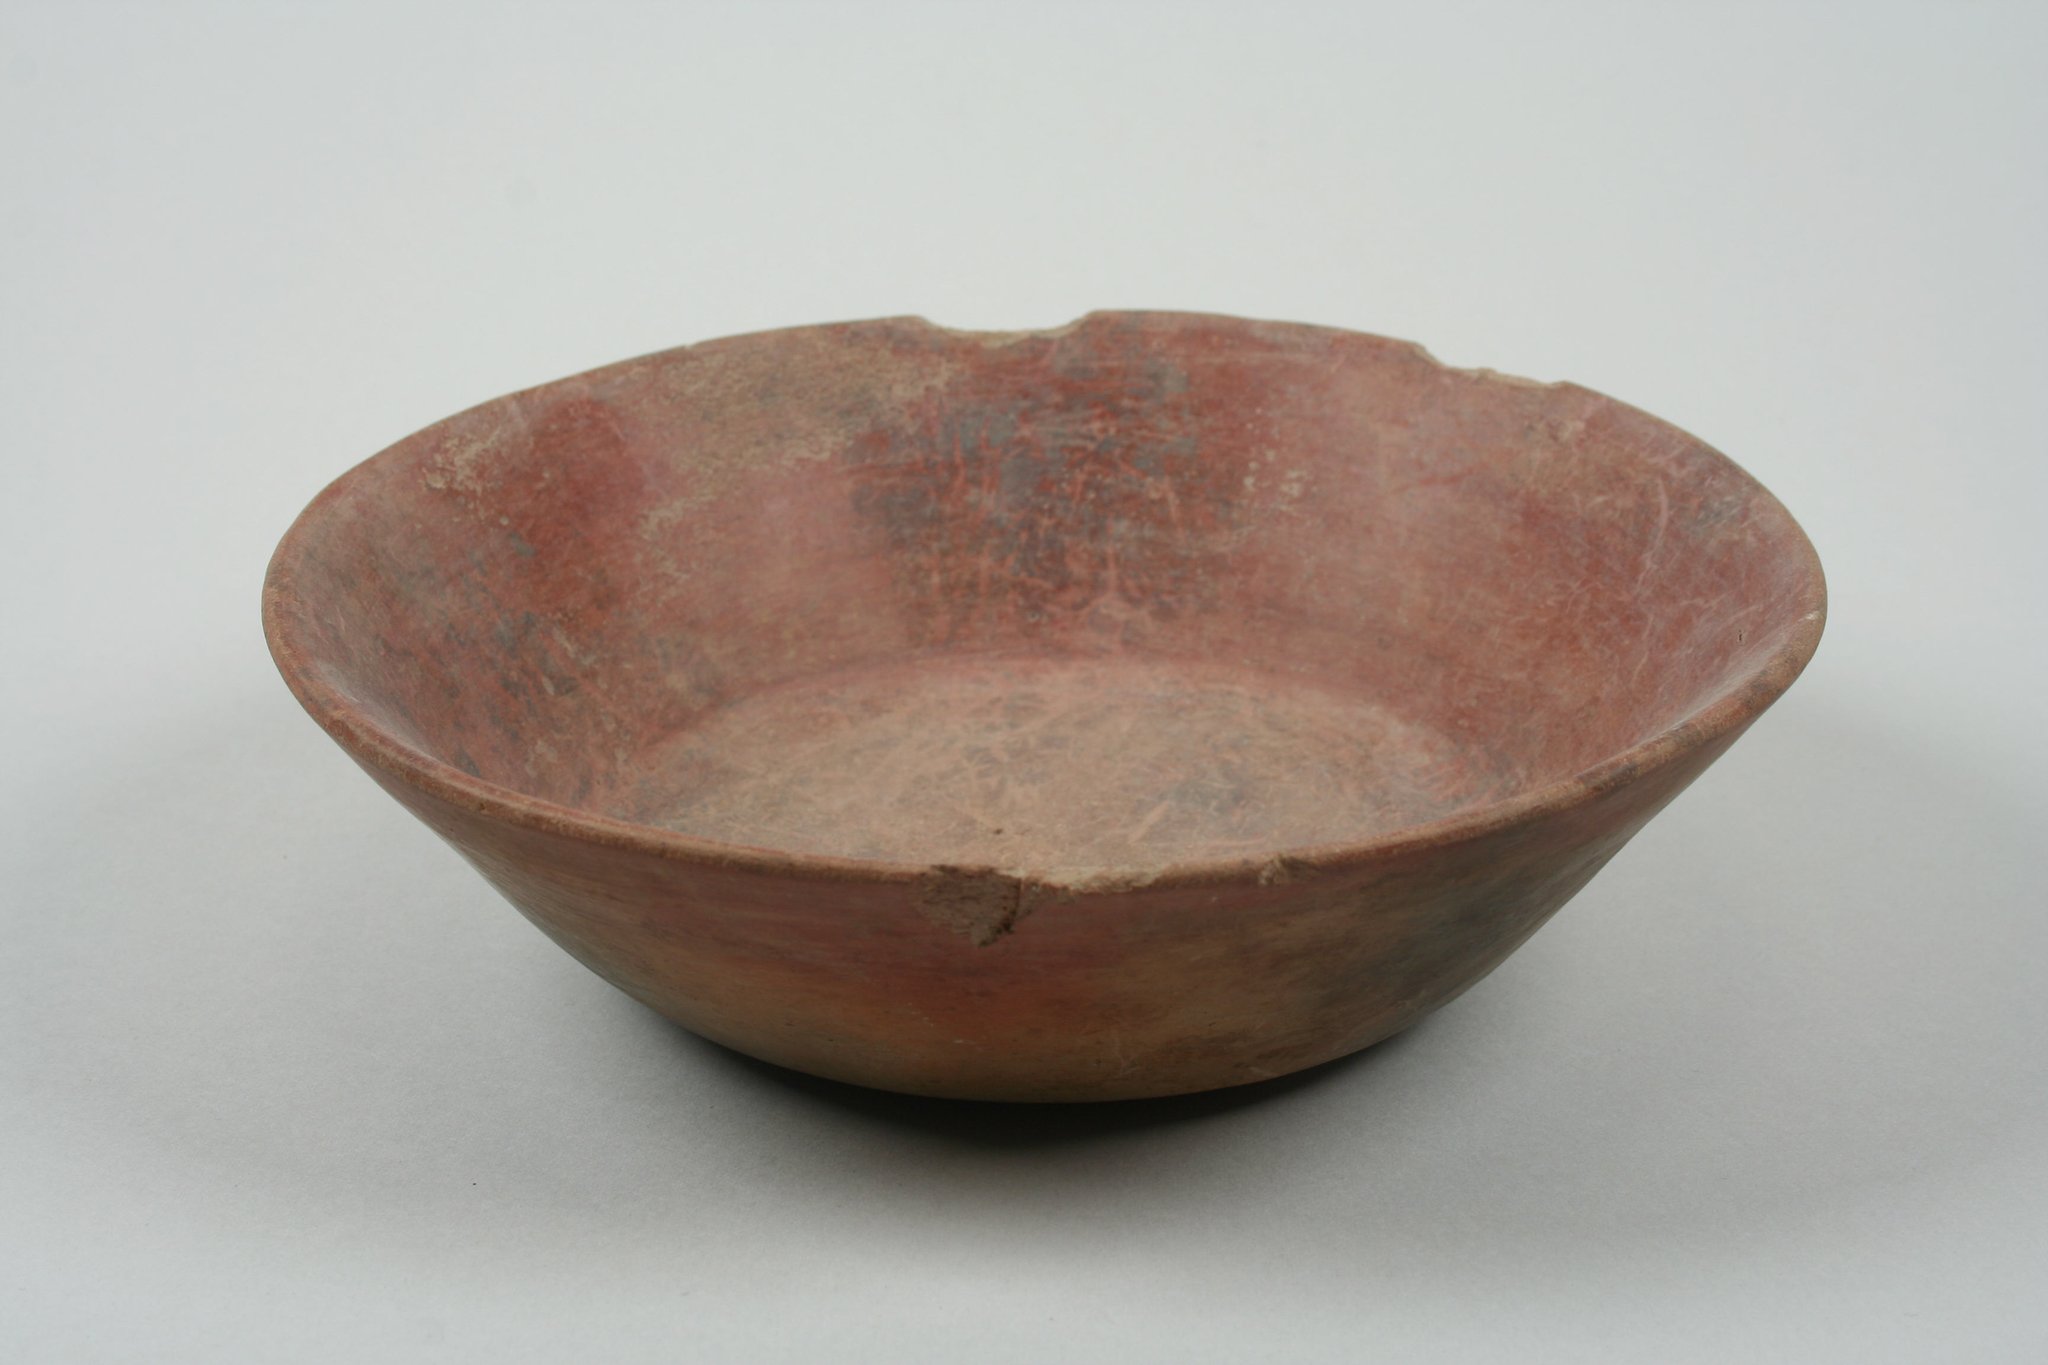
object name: bowl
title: Undecorated painted bowl with flaring sides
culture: paracas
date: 600-201 BCE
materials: ceramic, pigment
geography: peru